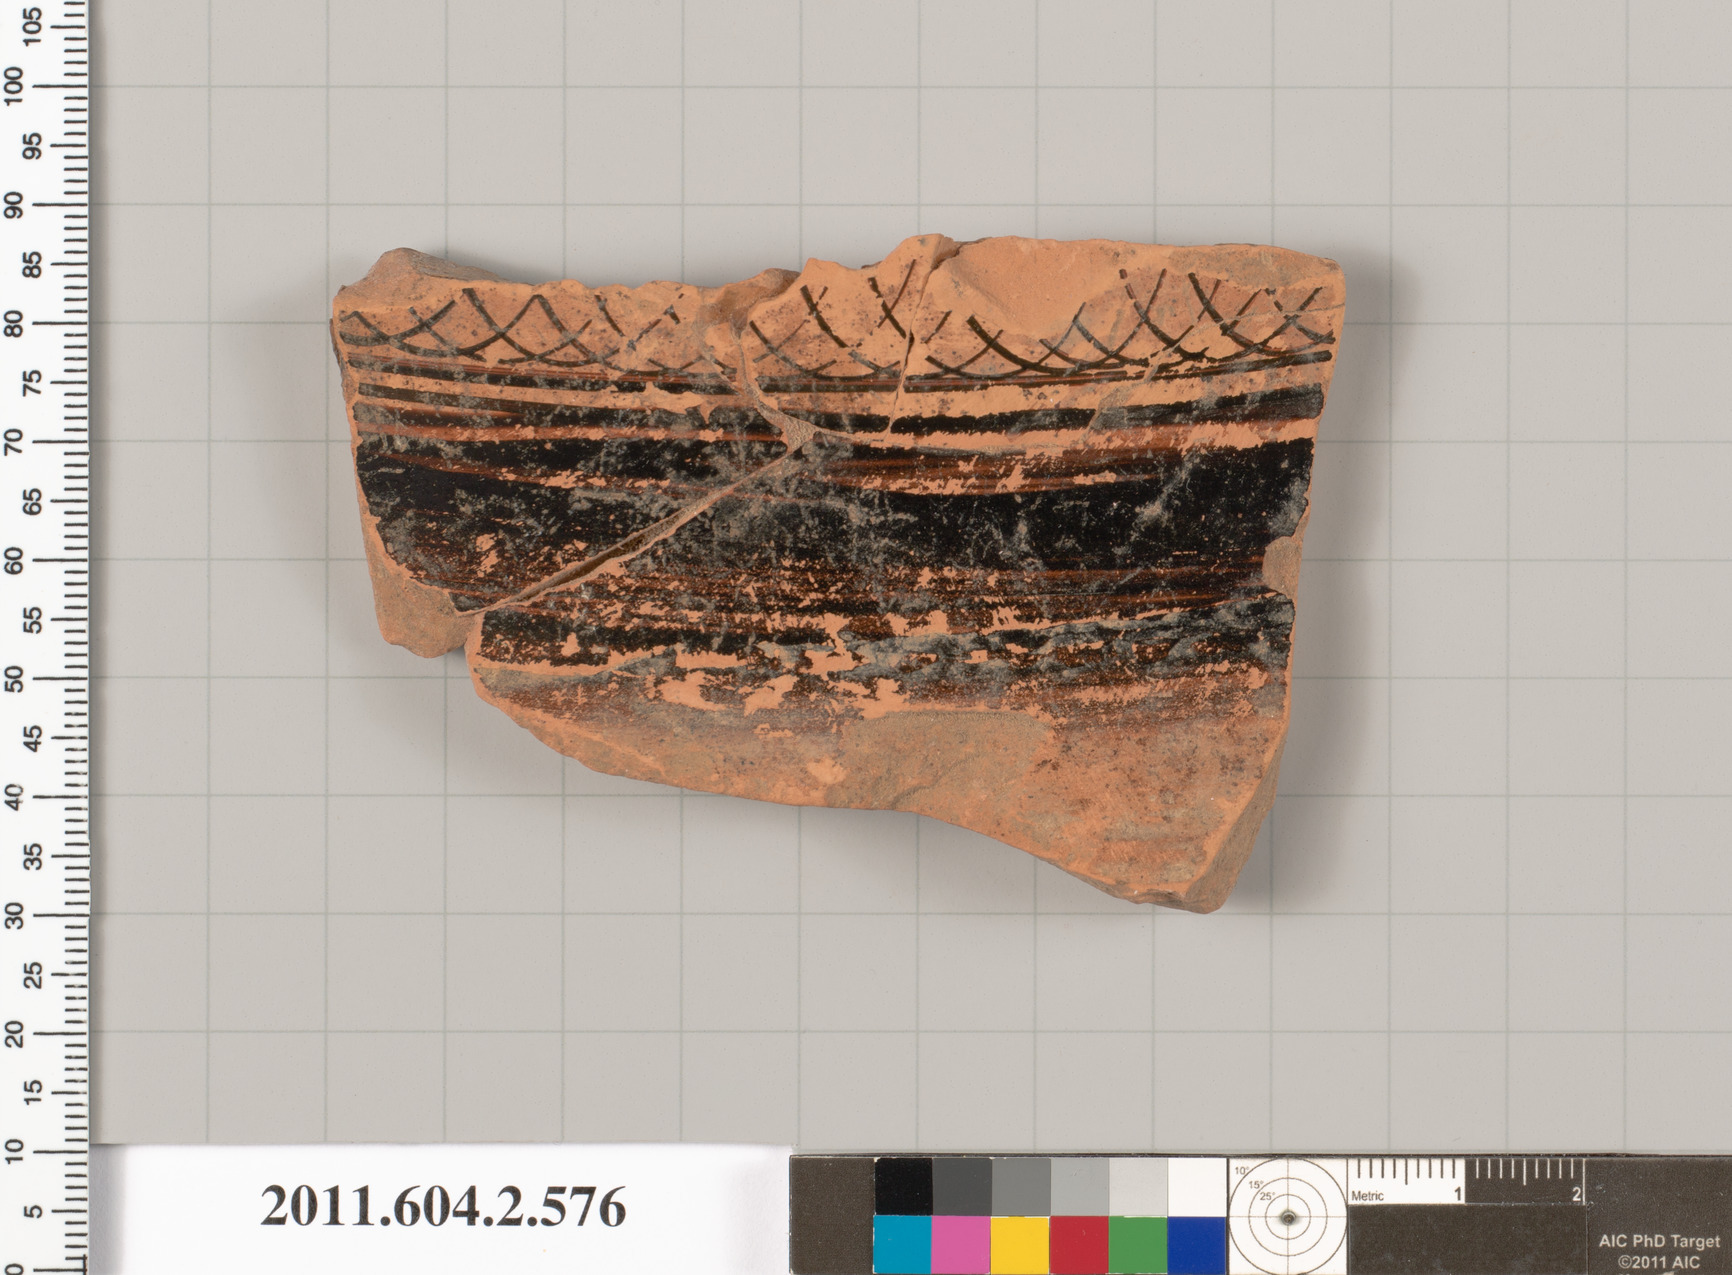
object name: column krater fragment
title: Terracotta fragment of a column-krater (bowl for mixing wine and water)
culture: greek, attic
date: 460-440 BCE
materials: terracotta